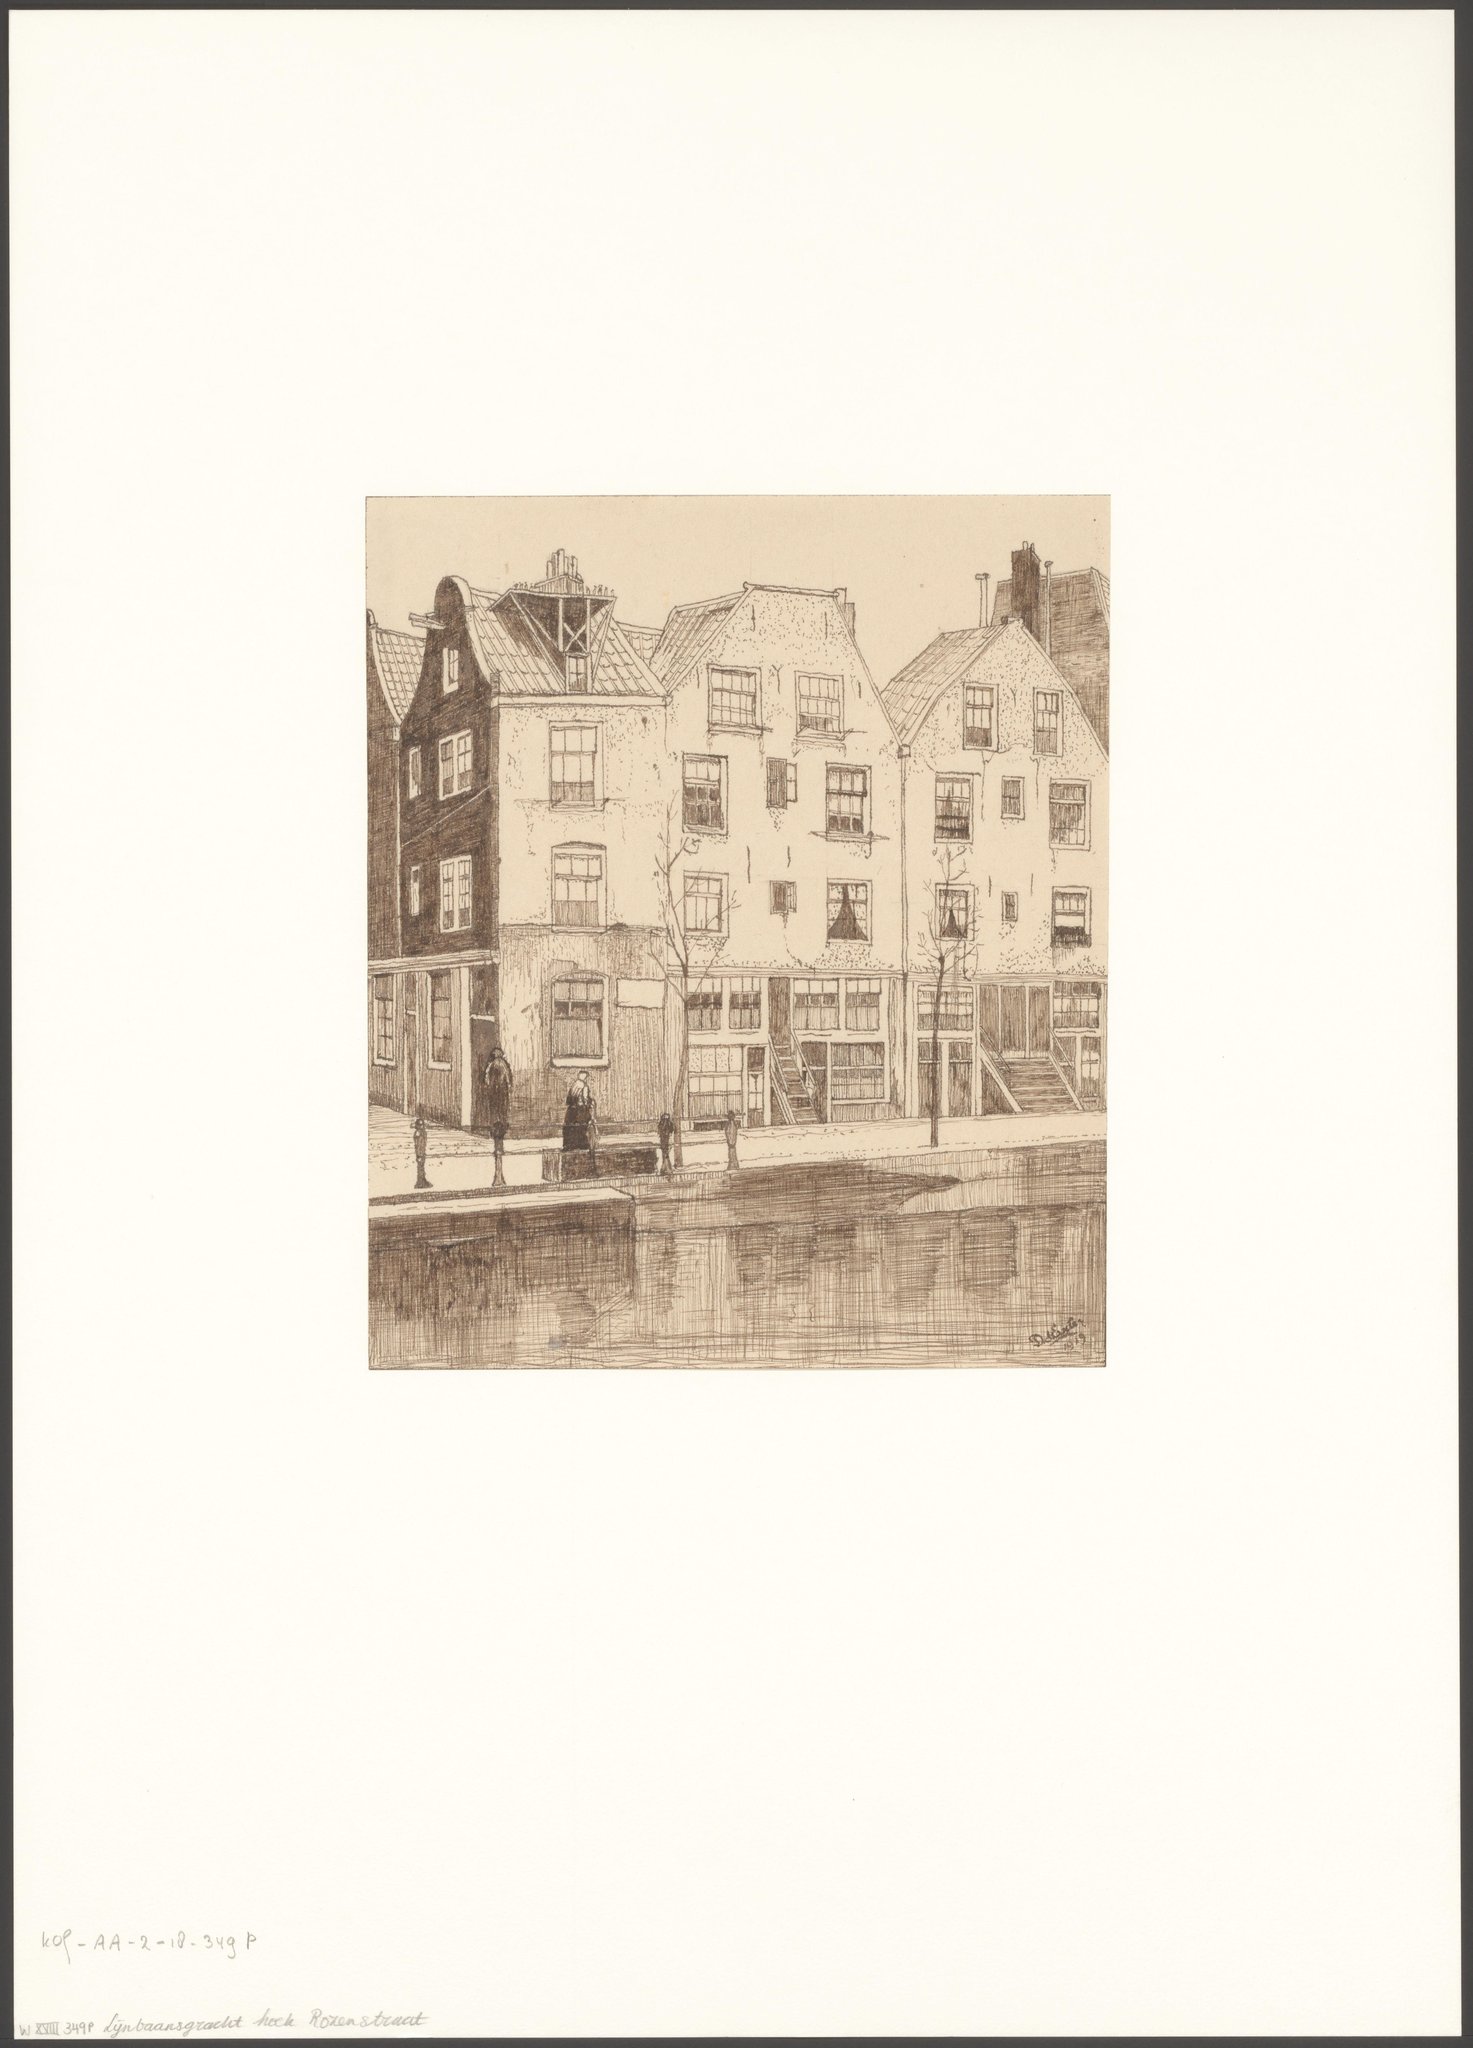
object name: drawing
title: Gezicht op de Lijnbaansgracht, hoek Rozenstraat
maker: Anonymous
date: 1919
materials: ink, paper, pencil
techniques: pen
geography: amsterdam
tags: city-view in general; 'veduta', canal, façade (of house or building)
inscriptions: signature and date: ‘D[...]E[...]ter / 1919’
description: Tekening binnen de Atlas Van Eck ingedeeld op wijknummer 18.